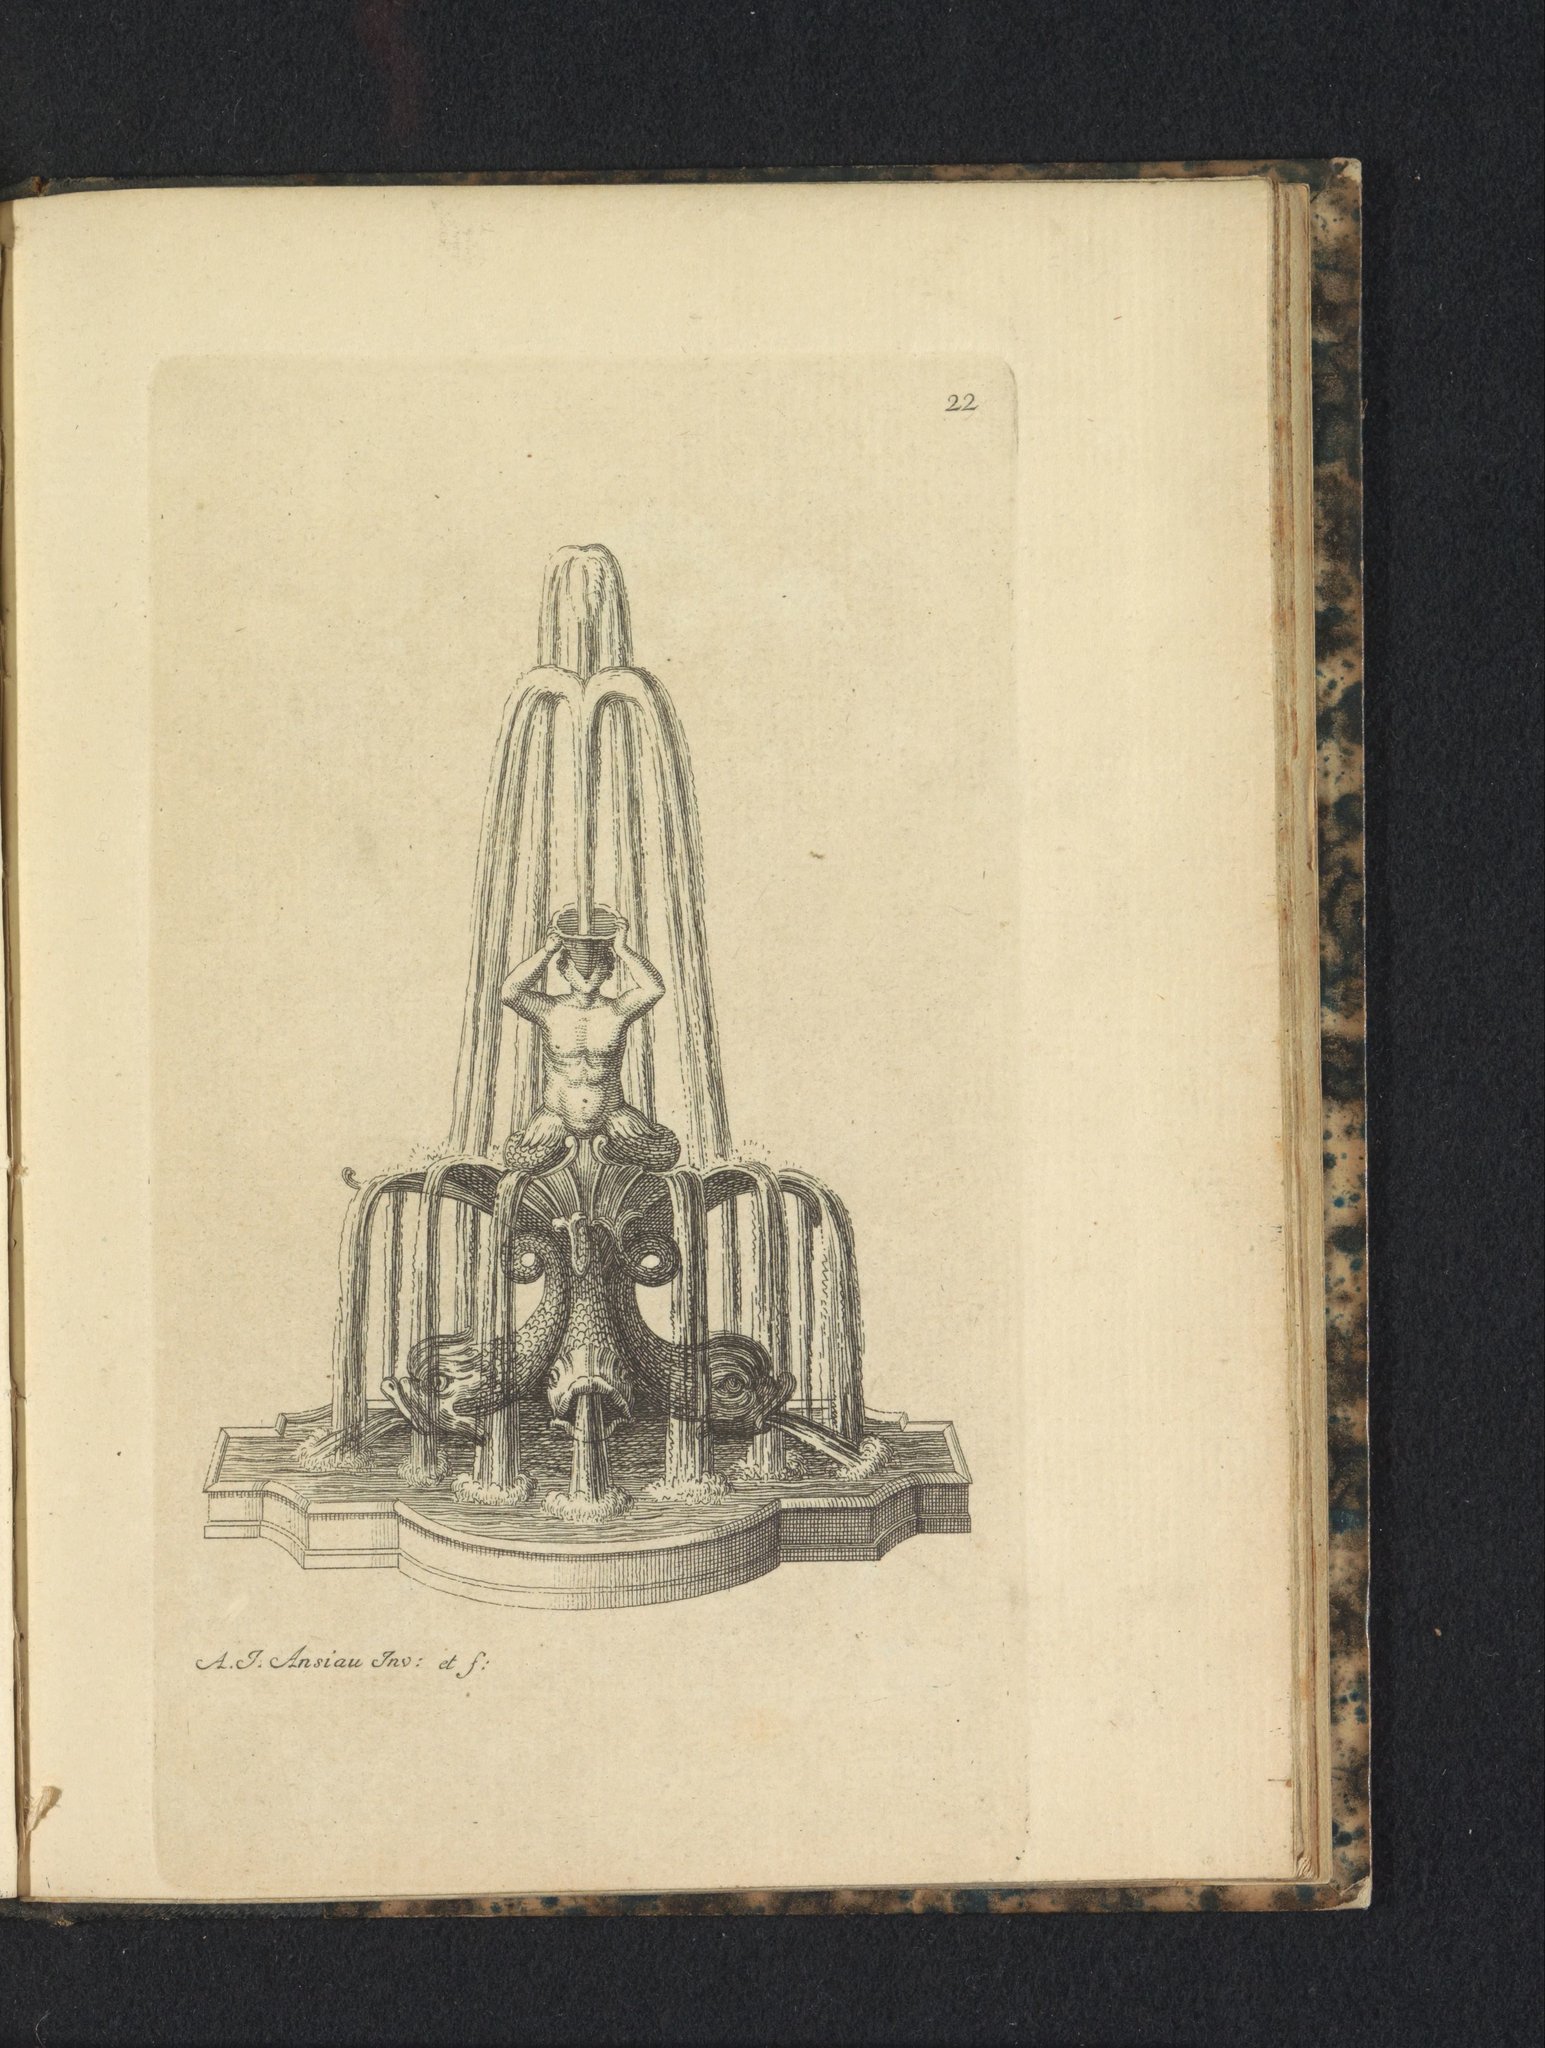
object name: print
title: Fontein met triton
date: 1772-1773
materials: paper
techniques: engraving, etching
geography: southern netherlands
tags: triton(s), piece of sculpture, reproduction of a piece of sculpture (+ clay, sand, etc. ~ arts), ornamental fountain, antwerp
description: Sculptuur van een fontein met een triton. Beeld gemaakt door Antoine-Jean Ansiau en zijn zoon, in de Wapperstraat. Genummerd rechtsboven in de plaat: 22. Onderdeel van de verzameling van figuren en beelden gemaakt van sneeuw in de straten van Antwerpen in januari 1772.